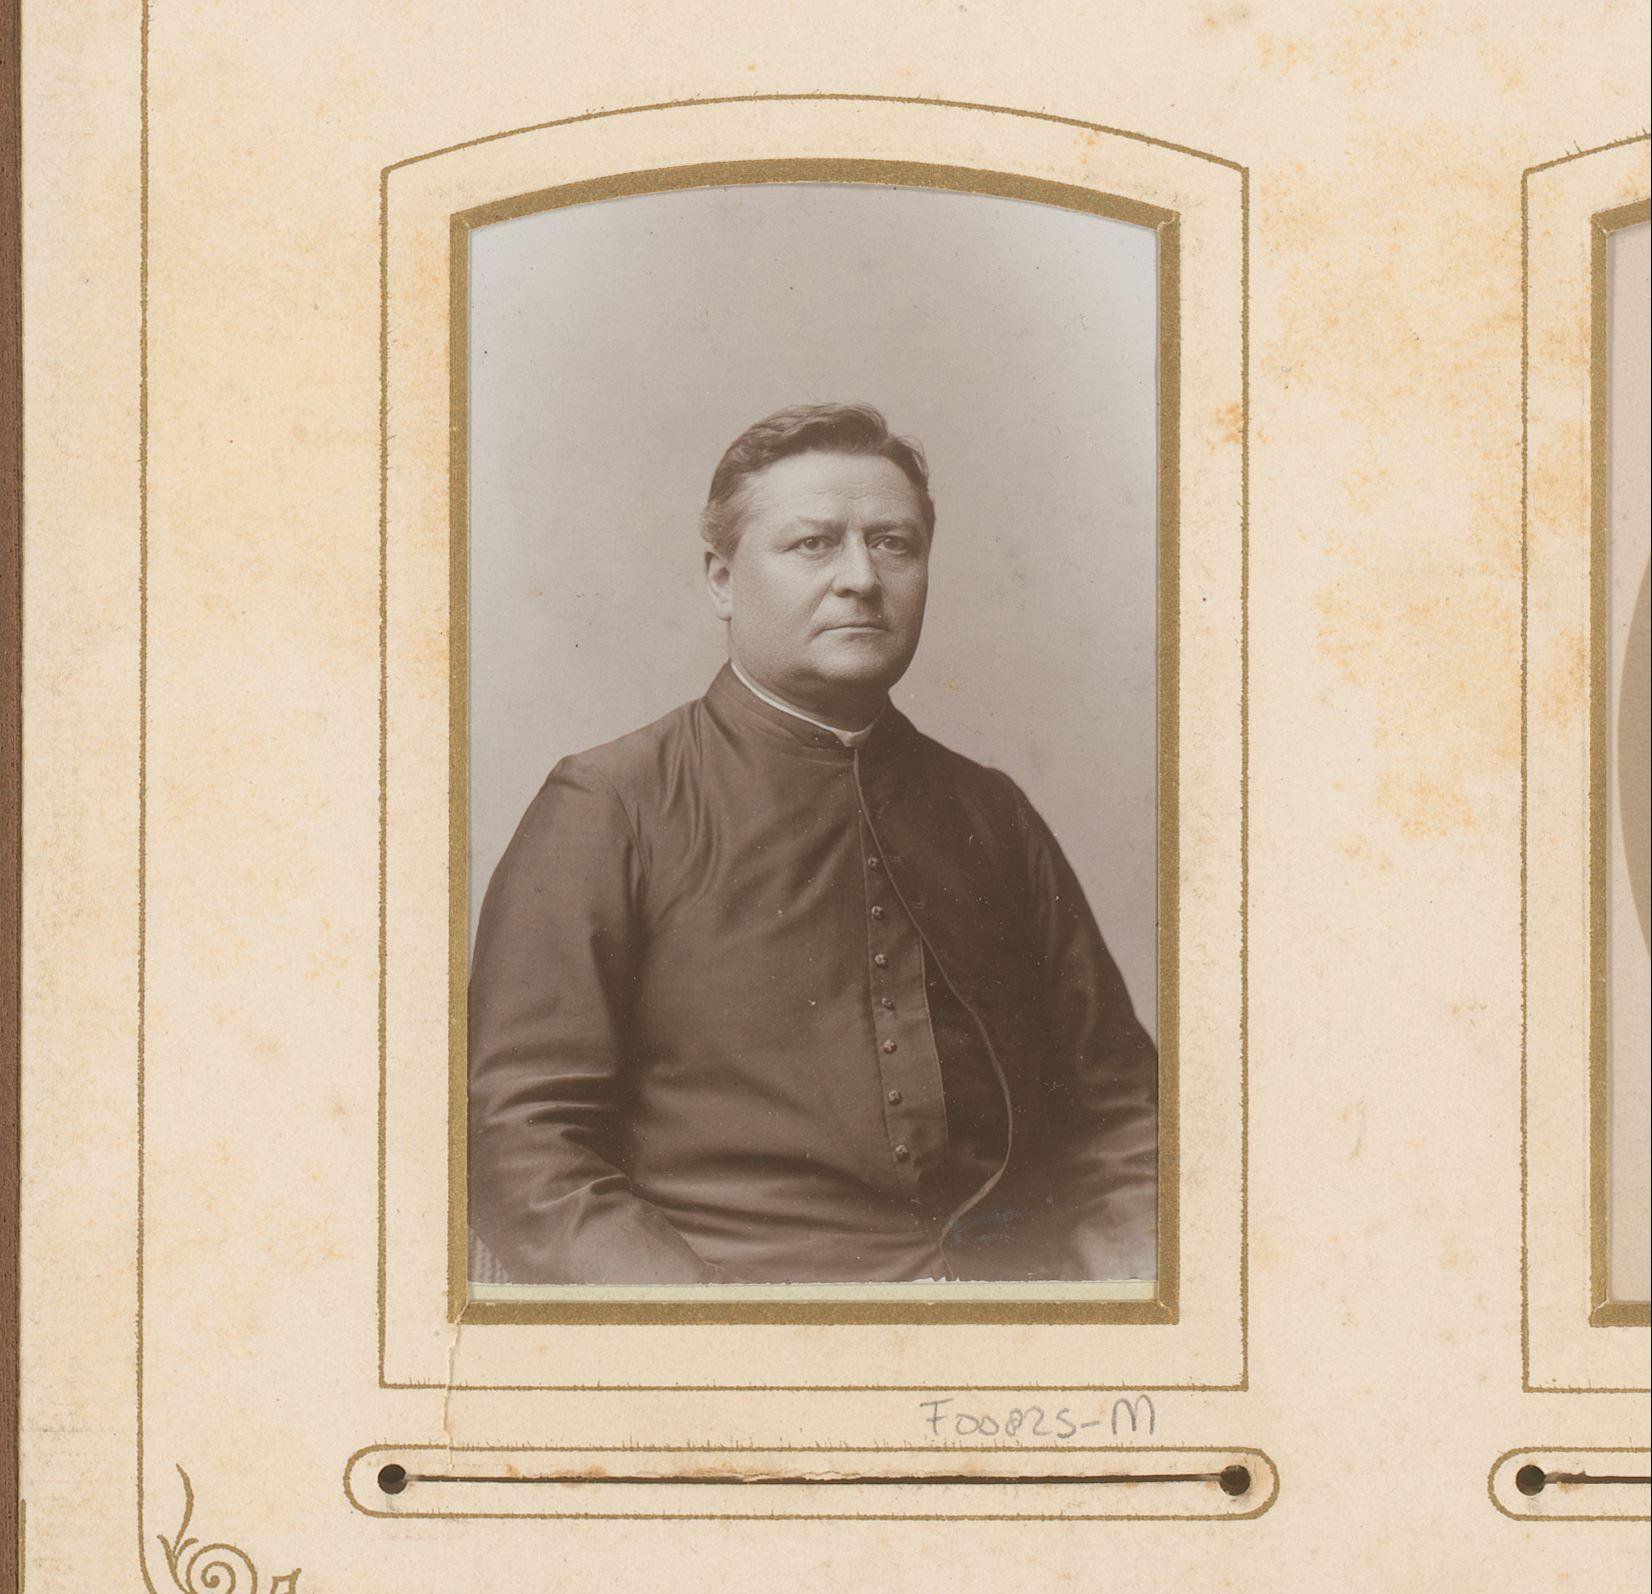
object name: photograph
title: Portret van een geestelijke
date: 1885-1906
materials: cardboard, photographic support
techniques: collodion silver print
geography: amsterdam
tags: theologian, historical persons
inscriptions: inscription: ‘opgericht 1864/ Amsterdam/ Wester markt, 19/ W. G. Kuijer & Zonen/ Hofphotographen/ Speciale Inrichting/ voor/ Vergrootingen’